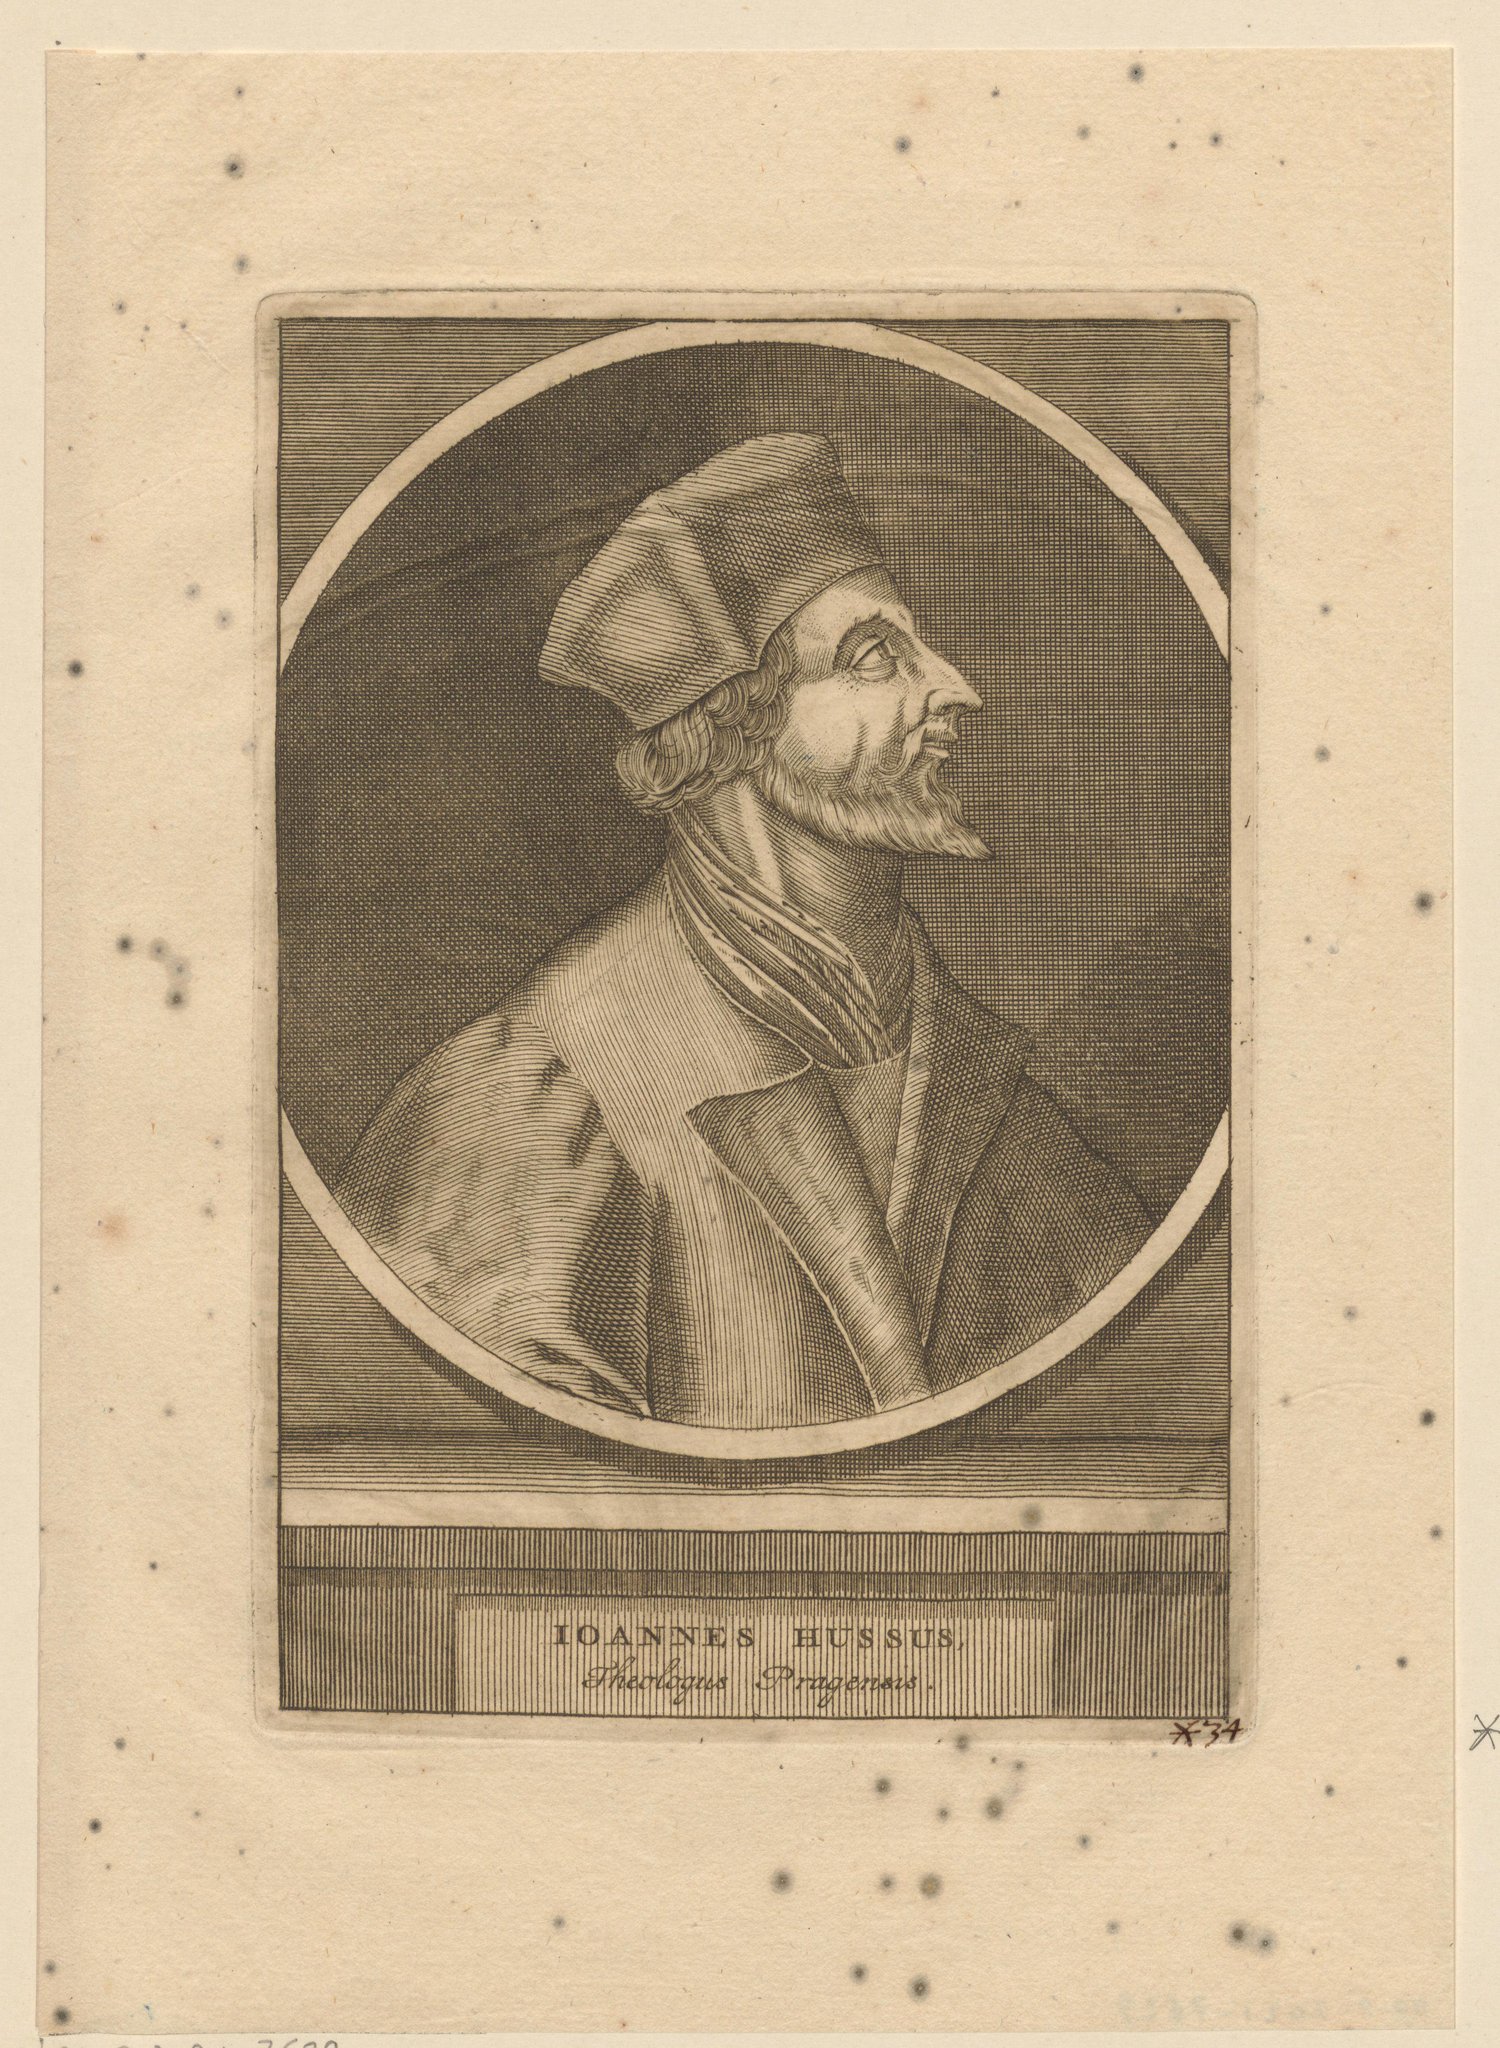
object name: print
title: Portret van Johannes Hus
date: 1690-1729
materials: paper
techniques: engraving, etching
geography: leiden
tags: theologian, historical persons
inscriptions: number: ‘*34’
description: Prent waarschijnlijk uit een editie van: Le miroir des portraits des premiers reformateurs des eglises protestantes. Leiden: Pieter van der Aa, [1690-1729]. Eerdere staat gebruikt in serie uit 1599 en publicaties uit 1602 en 1604.